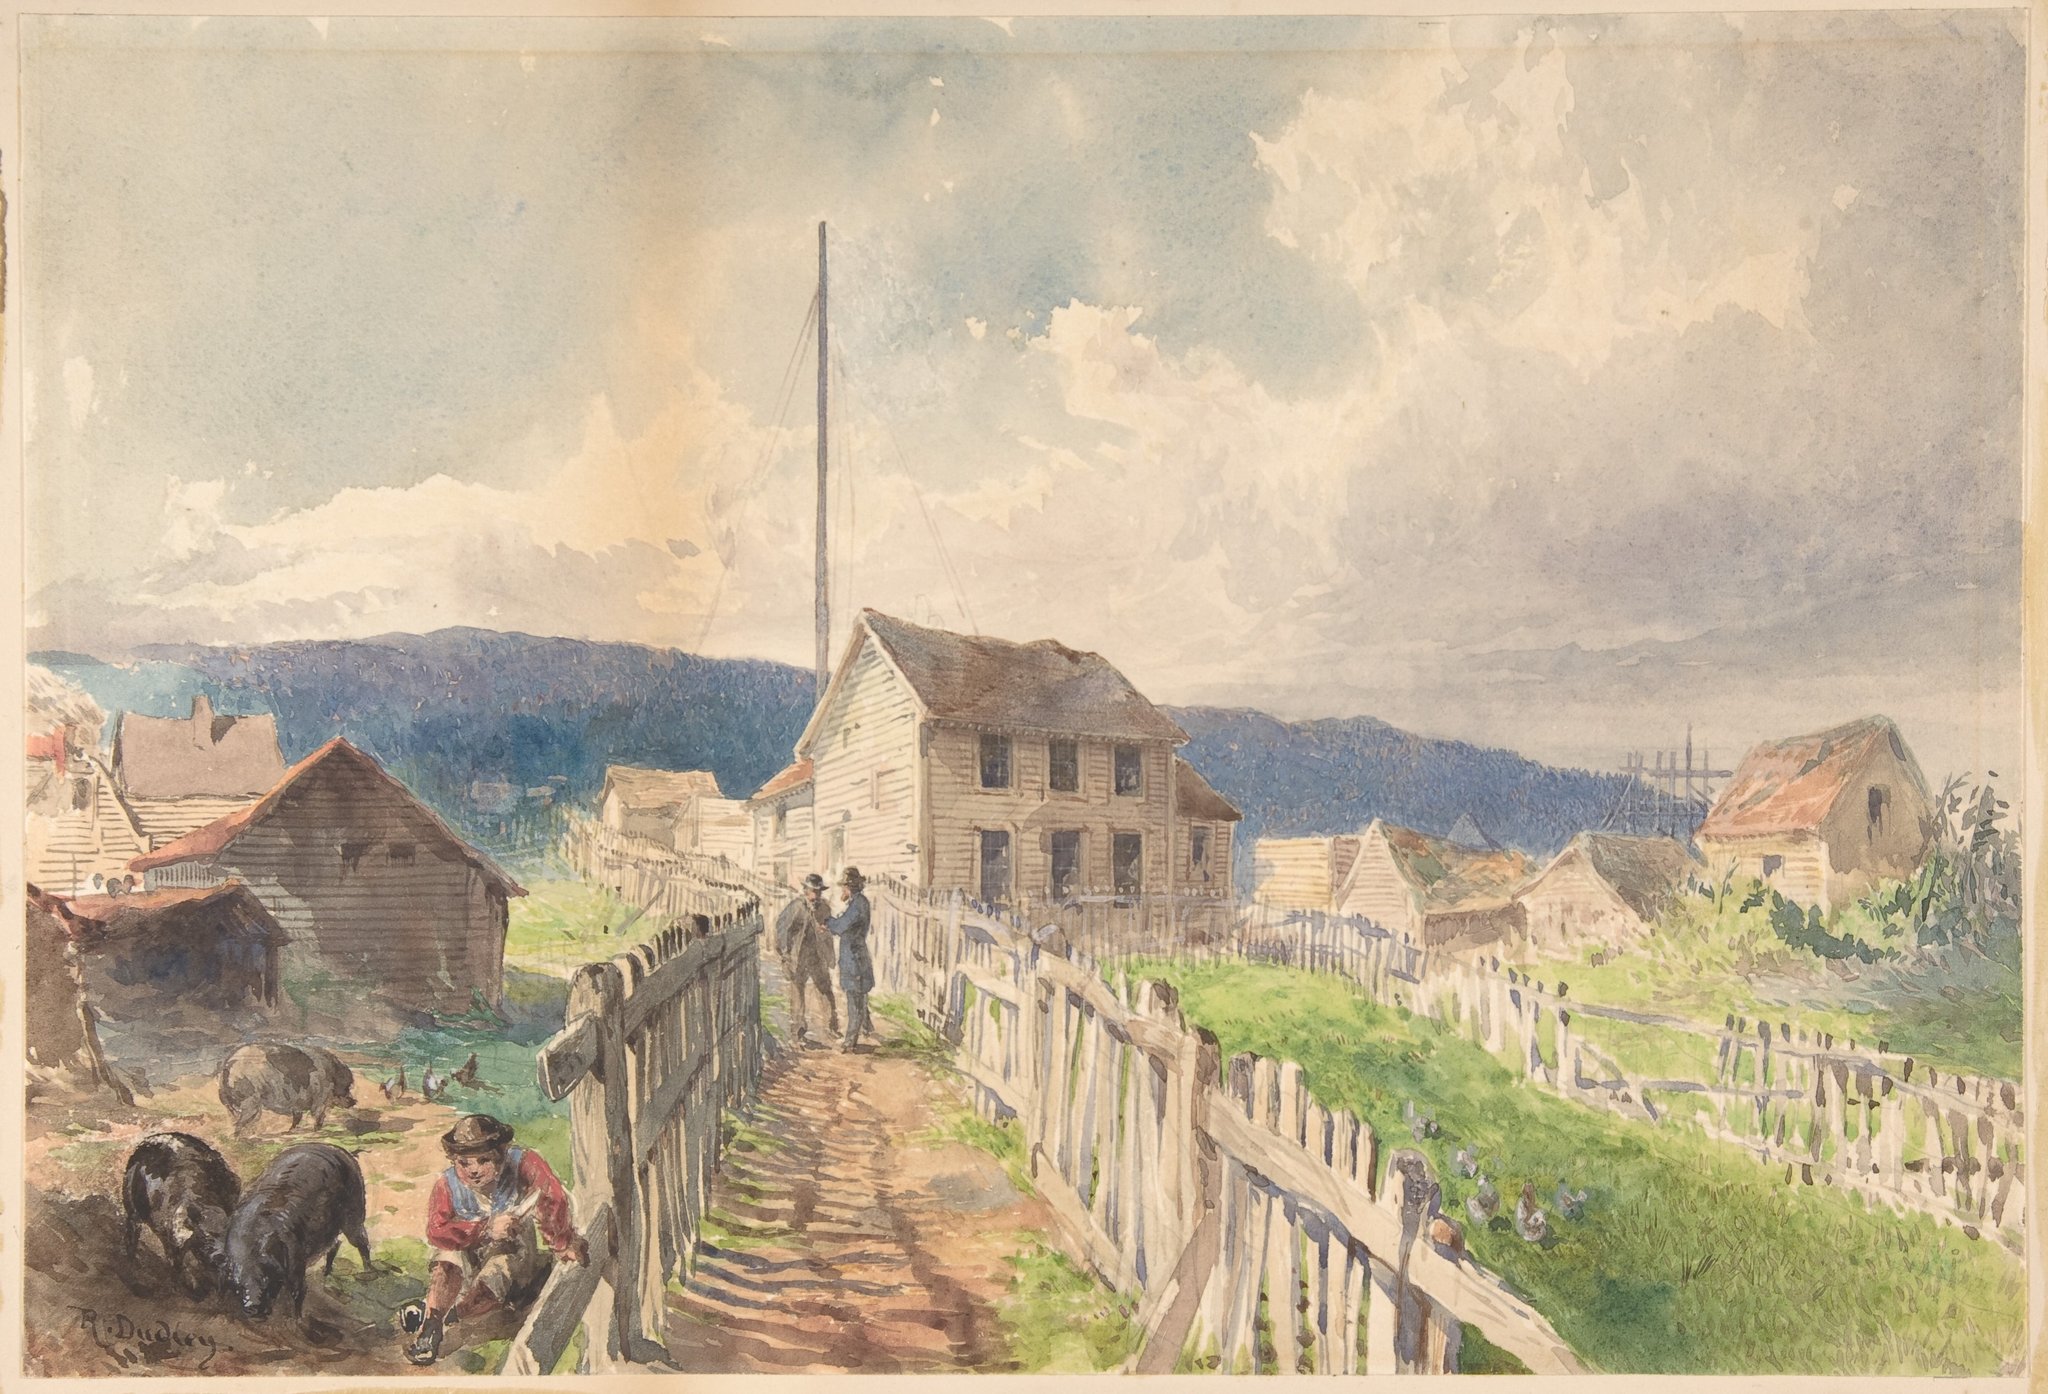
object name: drawing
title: First Telegraph House at Heart's Content, Newfoundland, 1866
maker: robert charles dudley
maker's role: artist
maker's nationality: british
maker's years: 1826-1909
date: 1866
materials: gouache, graphite, watercolor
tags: men,pigs,landscapes,transatlantic cable